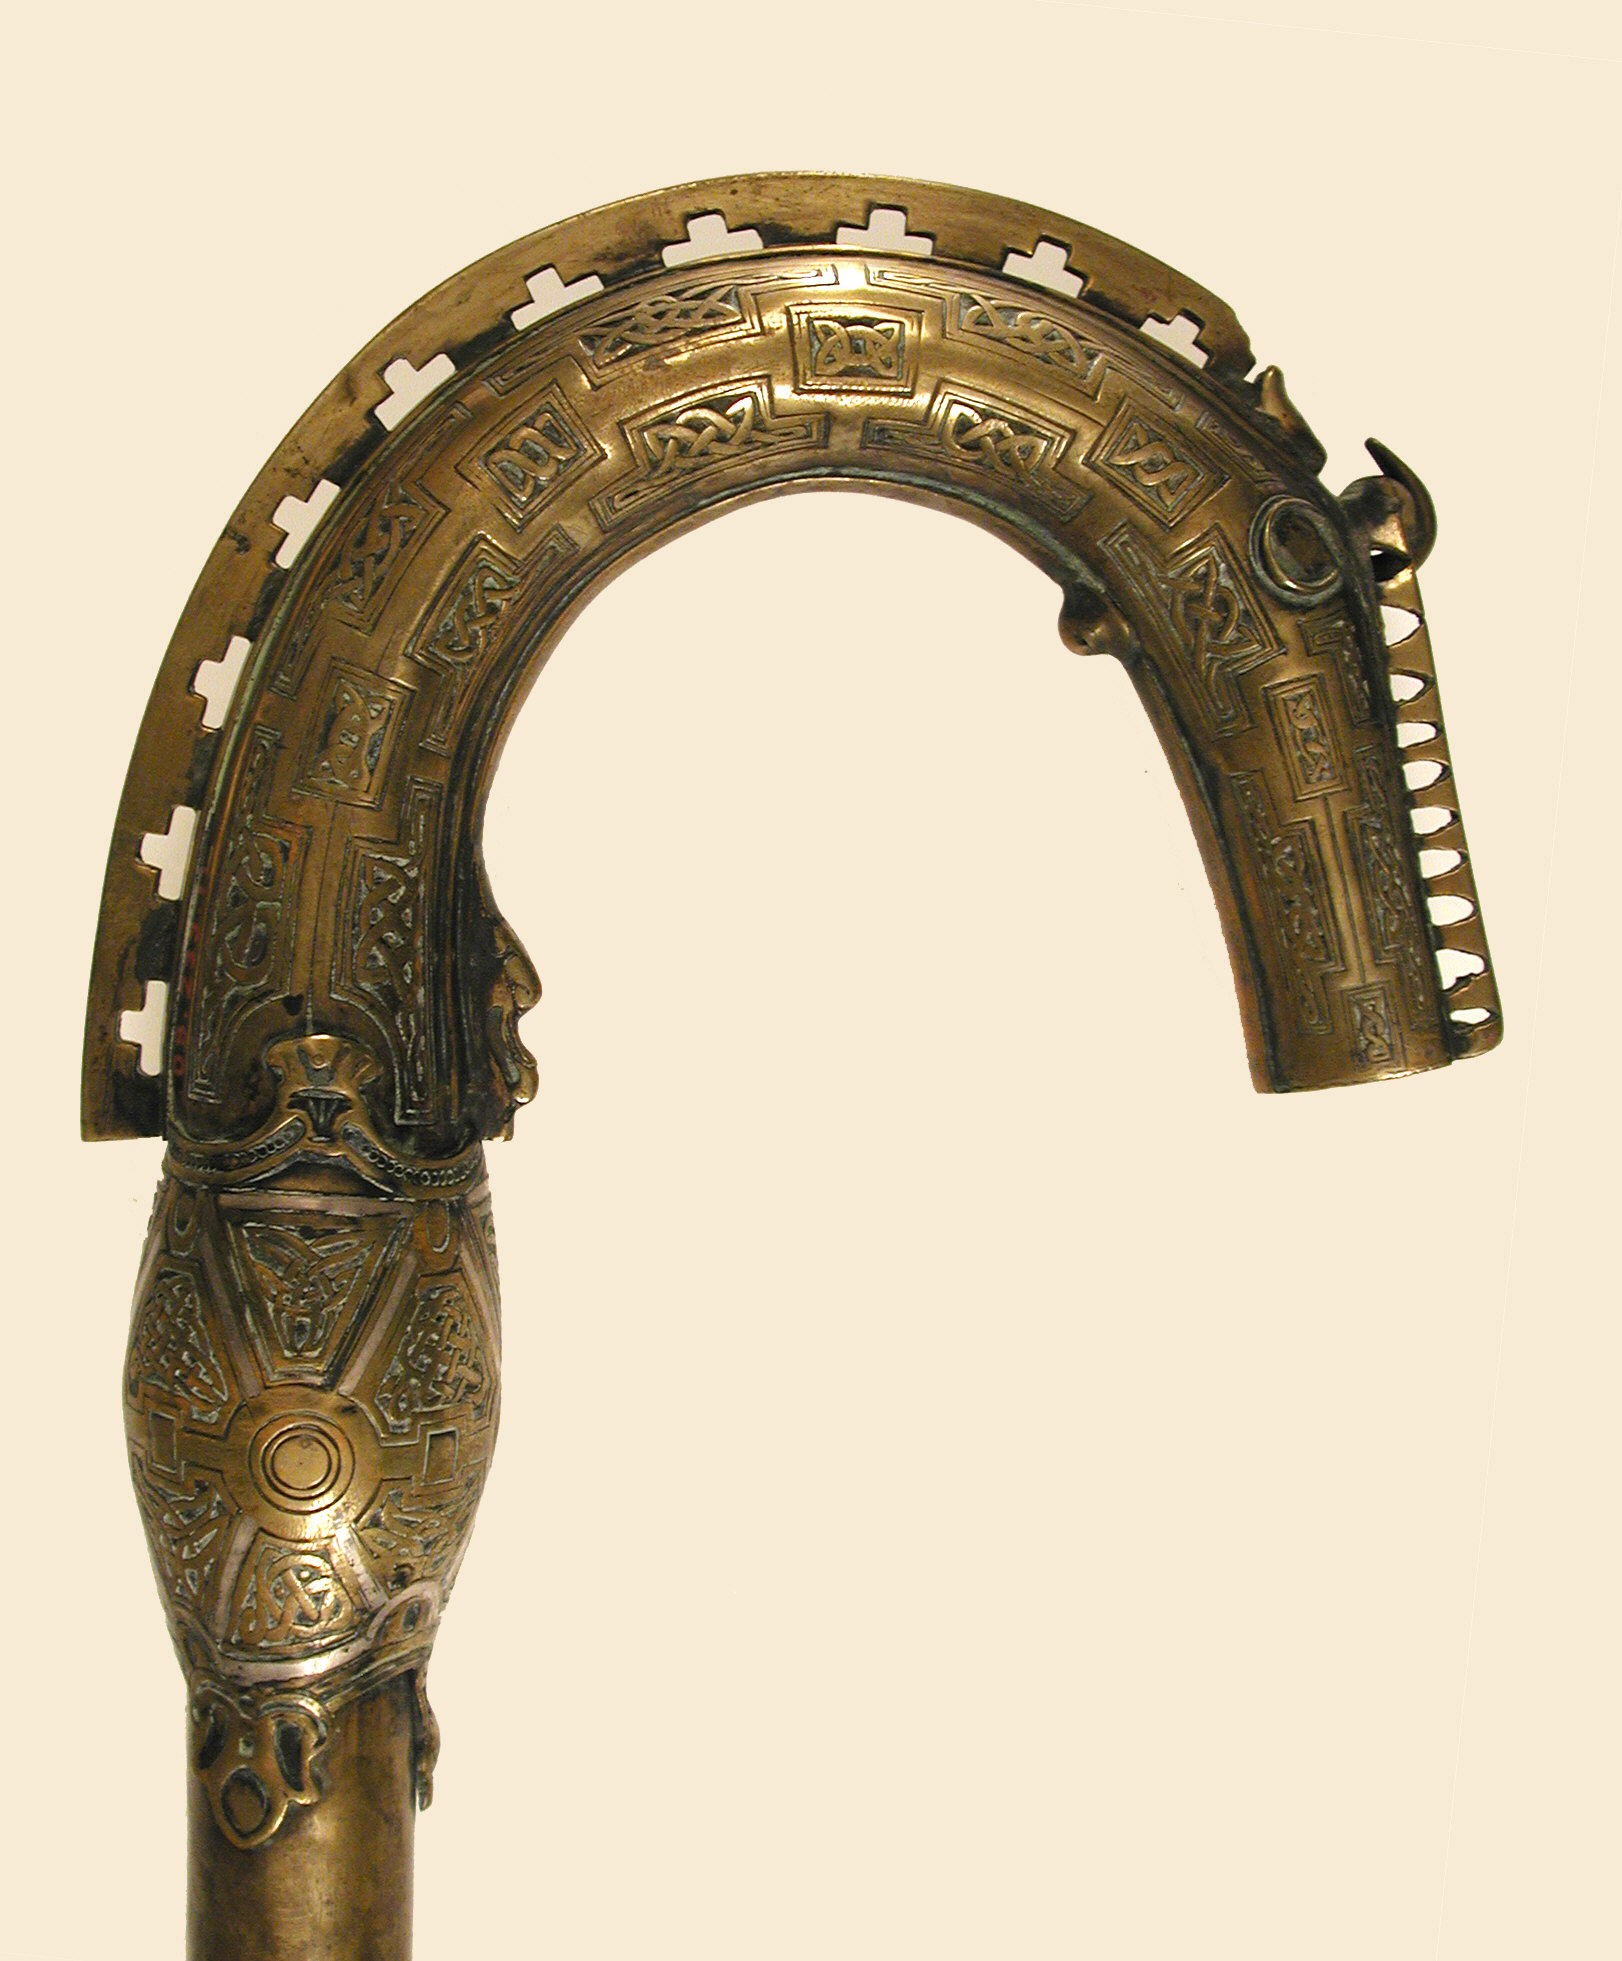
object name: crozier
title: Crozier of Saint Mura, of Fahan, County Donegal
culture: irish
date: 1901-1933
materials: bronze, silver, stone